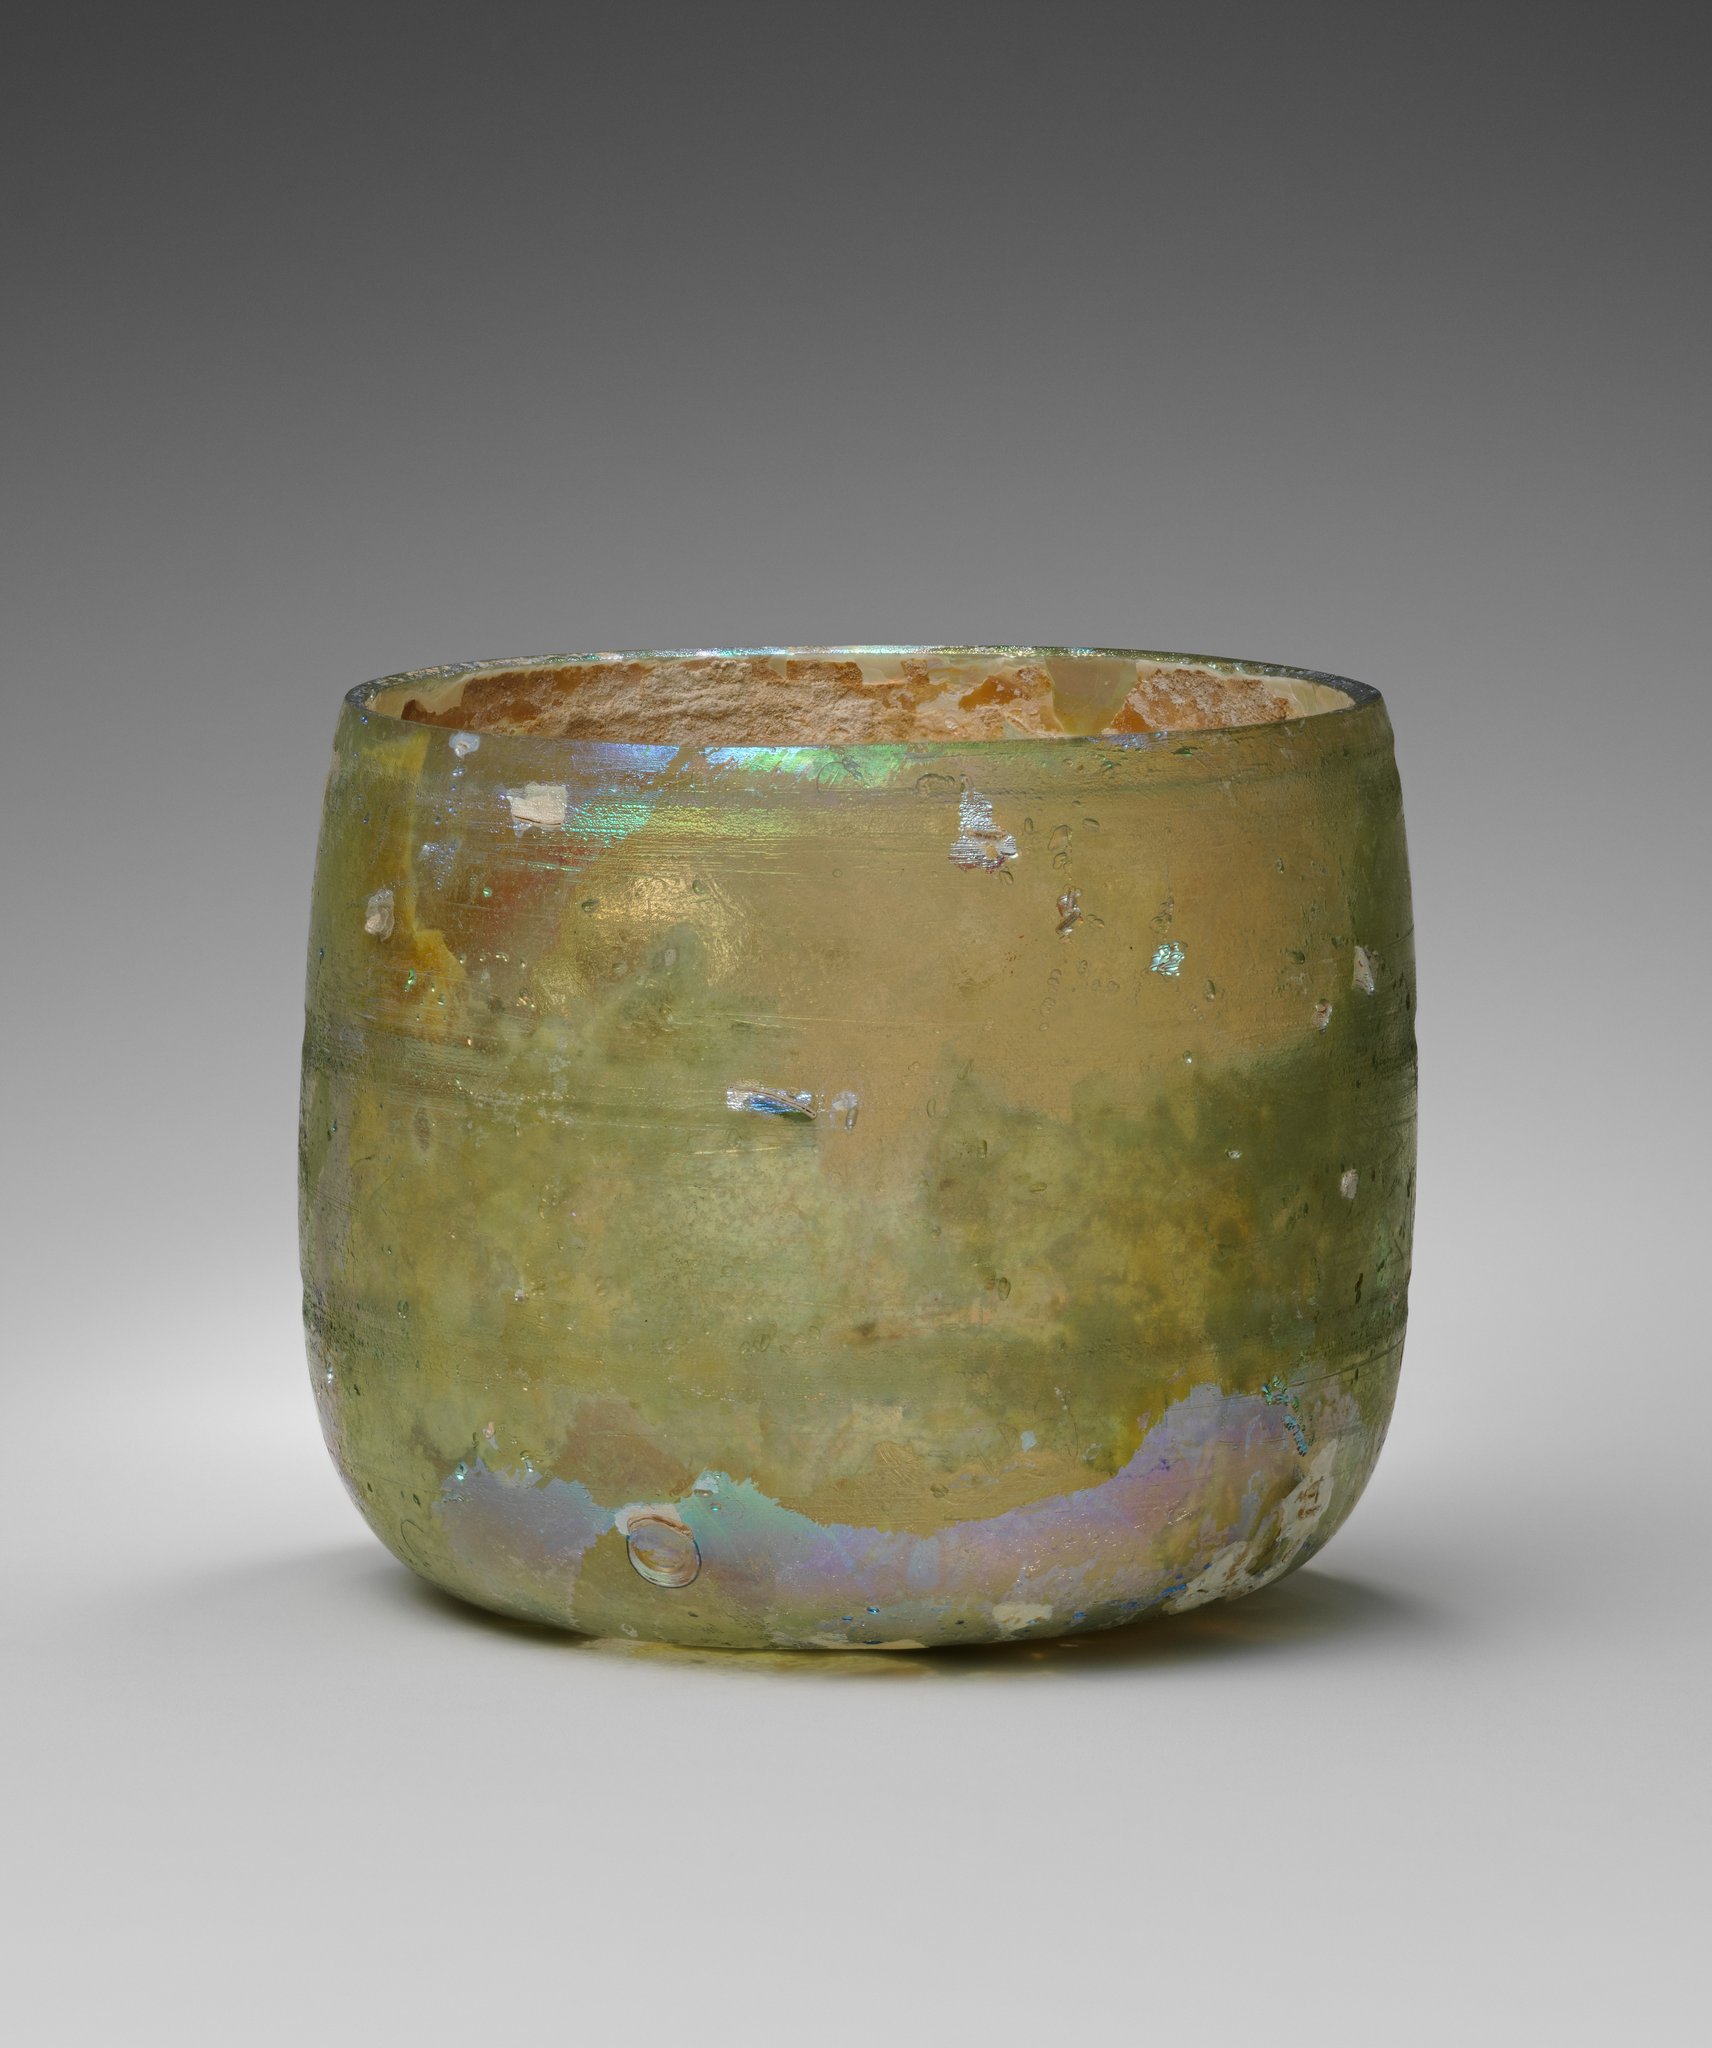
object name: cup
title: Glass cup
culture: roman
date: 1-100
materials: glass